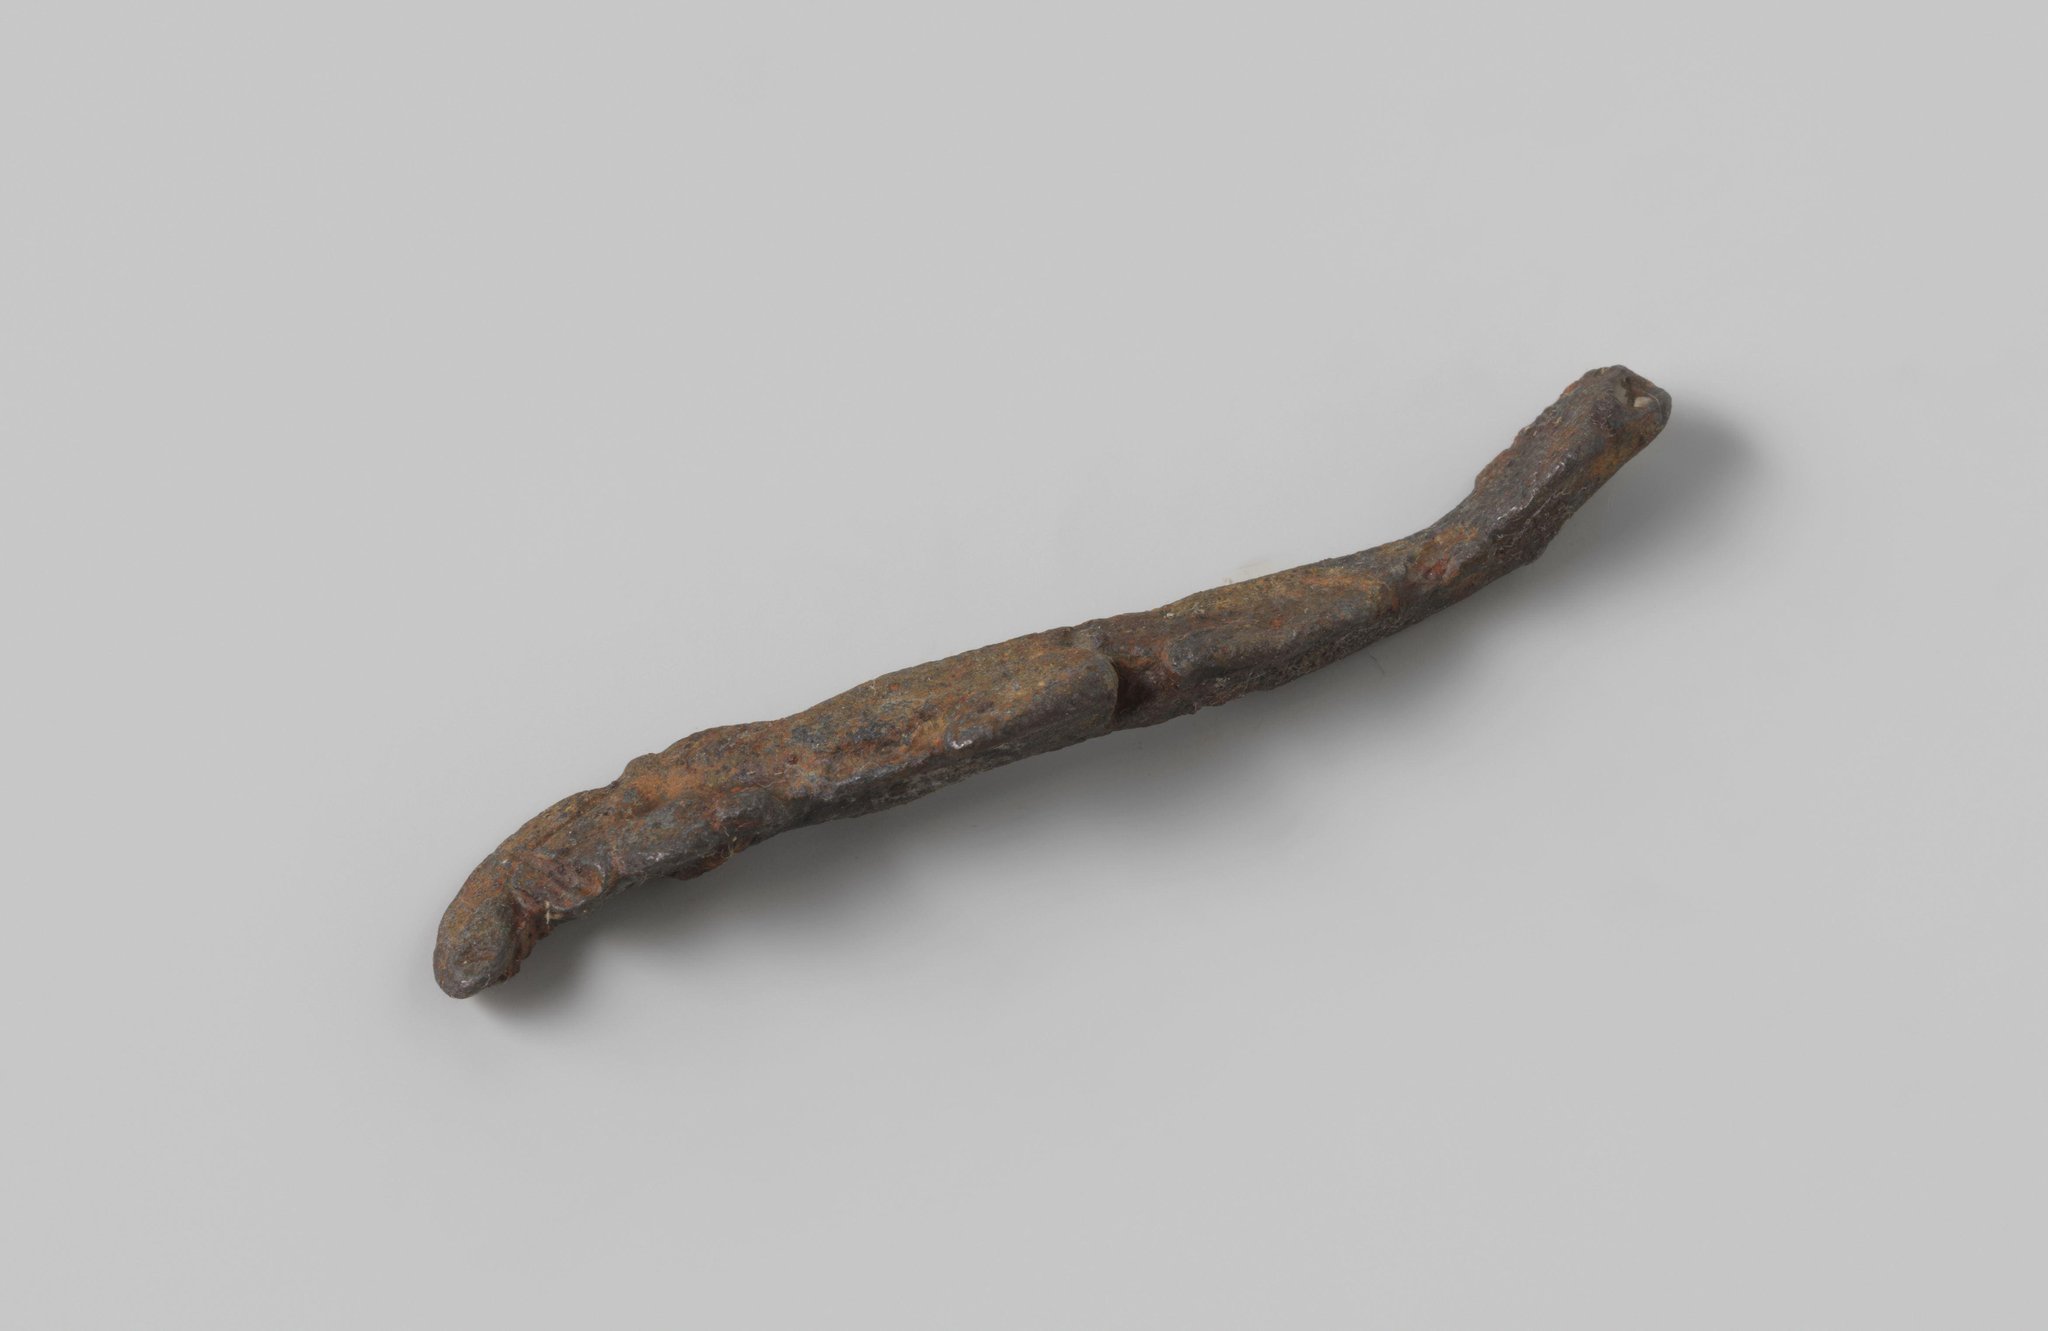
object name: cartridge shell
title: Beslag van patroonhuls uit het wrak van de Oost-Indiëvaarder Hollandia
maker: Anonymous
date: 1700-1743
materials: lead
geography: netherlands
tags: verenigde oostindische compagnie, hollandia (schip), annet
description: Cartridge case, tube solder; id. NG 1979-205H549.